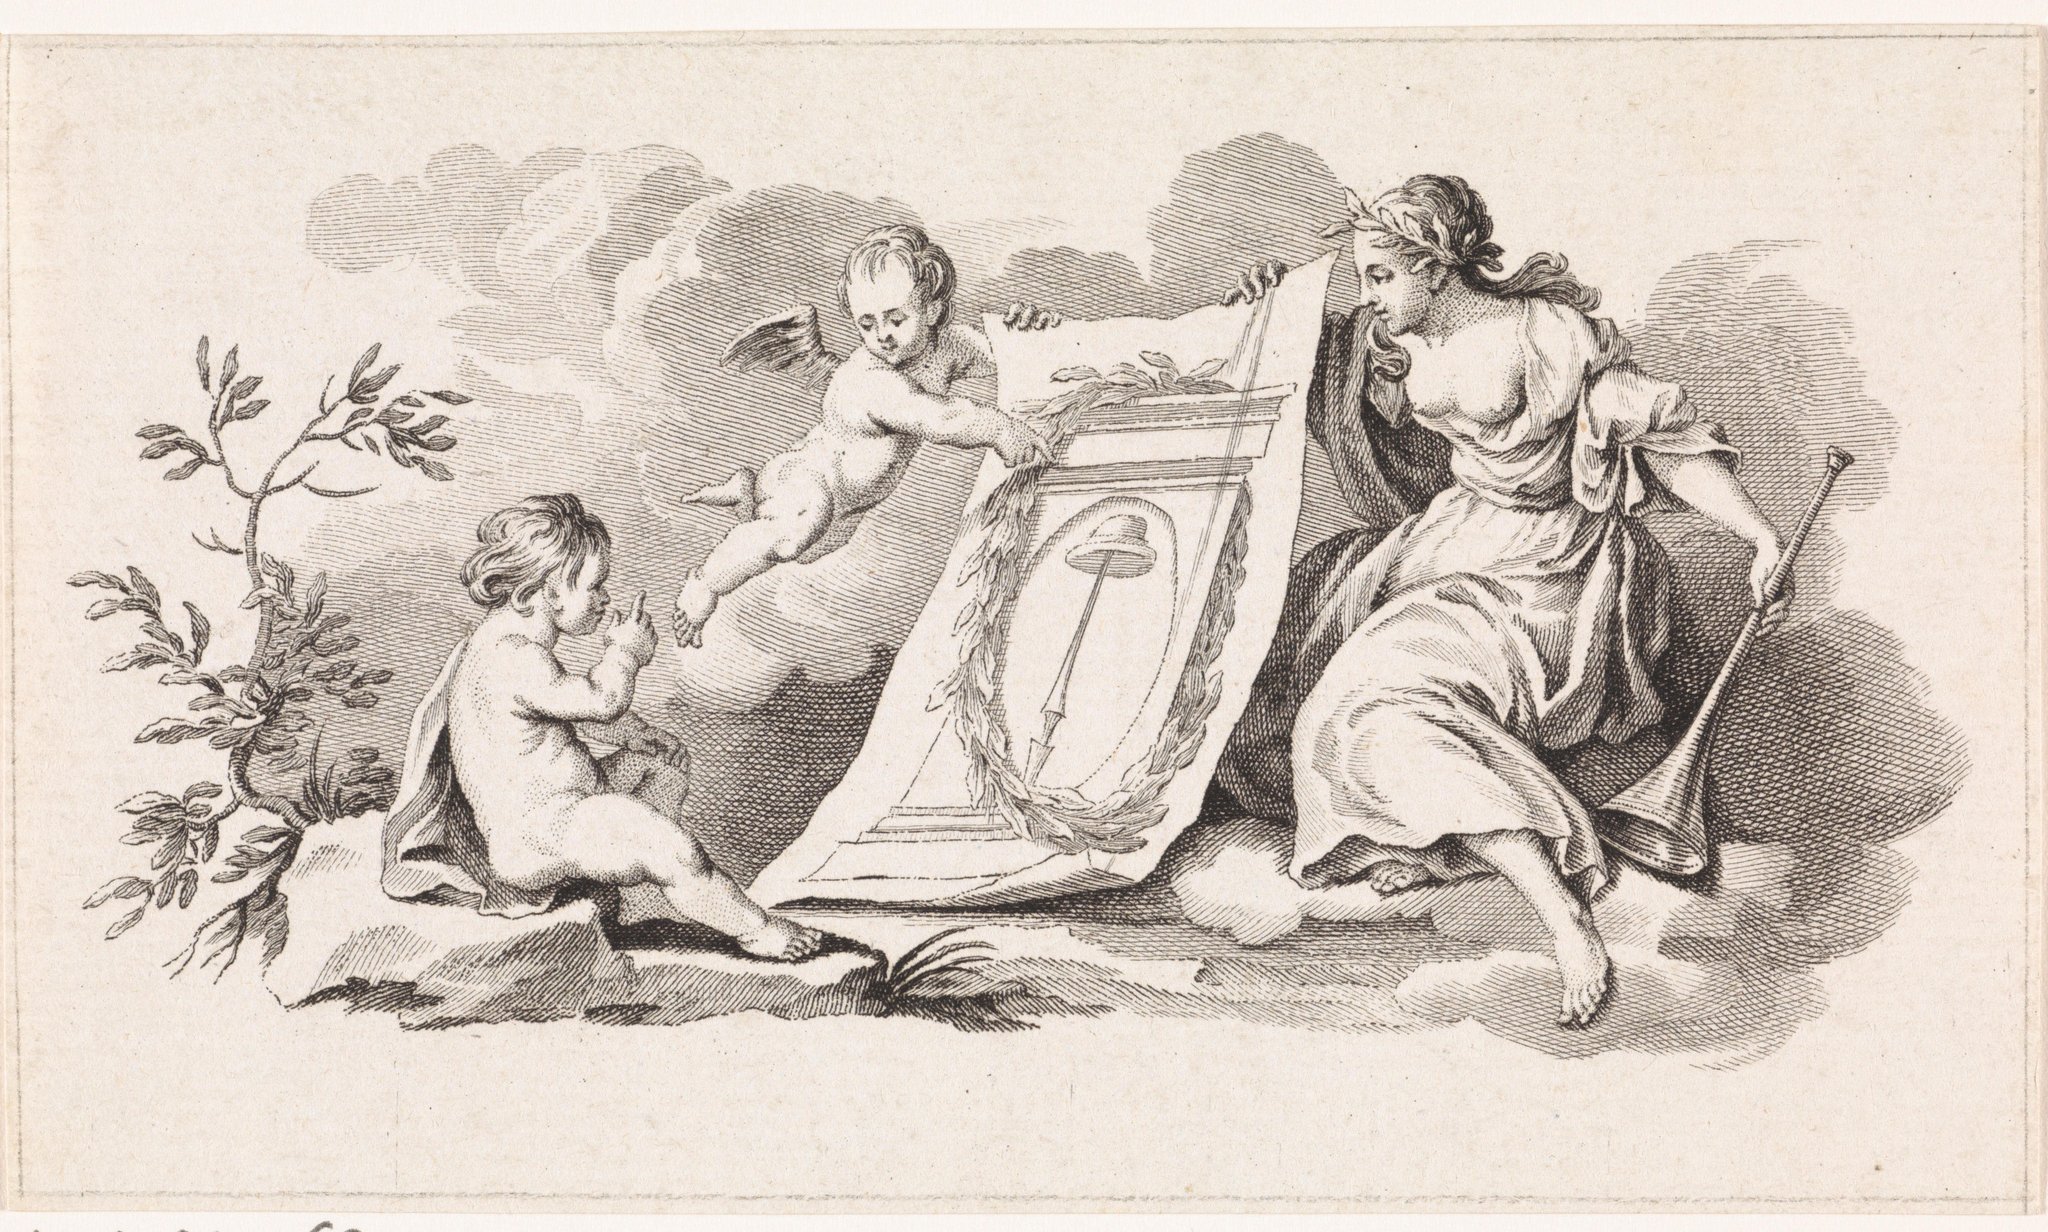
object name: print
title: Vrouw en twee putti met een blad waarop de vrijheidshoed op een lans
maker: reinier vinkeles (i)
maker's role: draughtsman, print maker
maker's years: 1741-1816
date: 1751-1816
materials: paper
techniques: engraving, etching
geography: amsterdam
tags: cupids: 'amores', 'amoretti', 'putti', freedom, liberty; 'libertà' (ripa) (+ symbolical representation of concept)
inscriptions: collector's mark: Lugt 2228